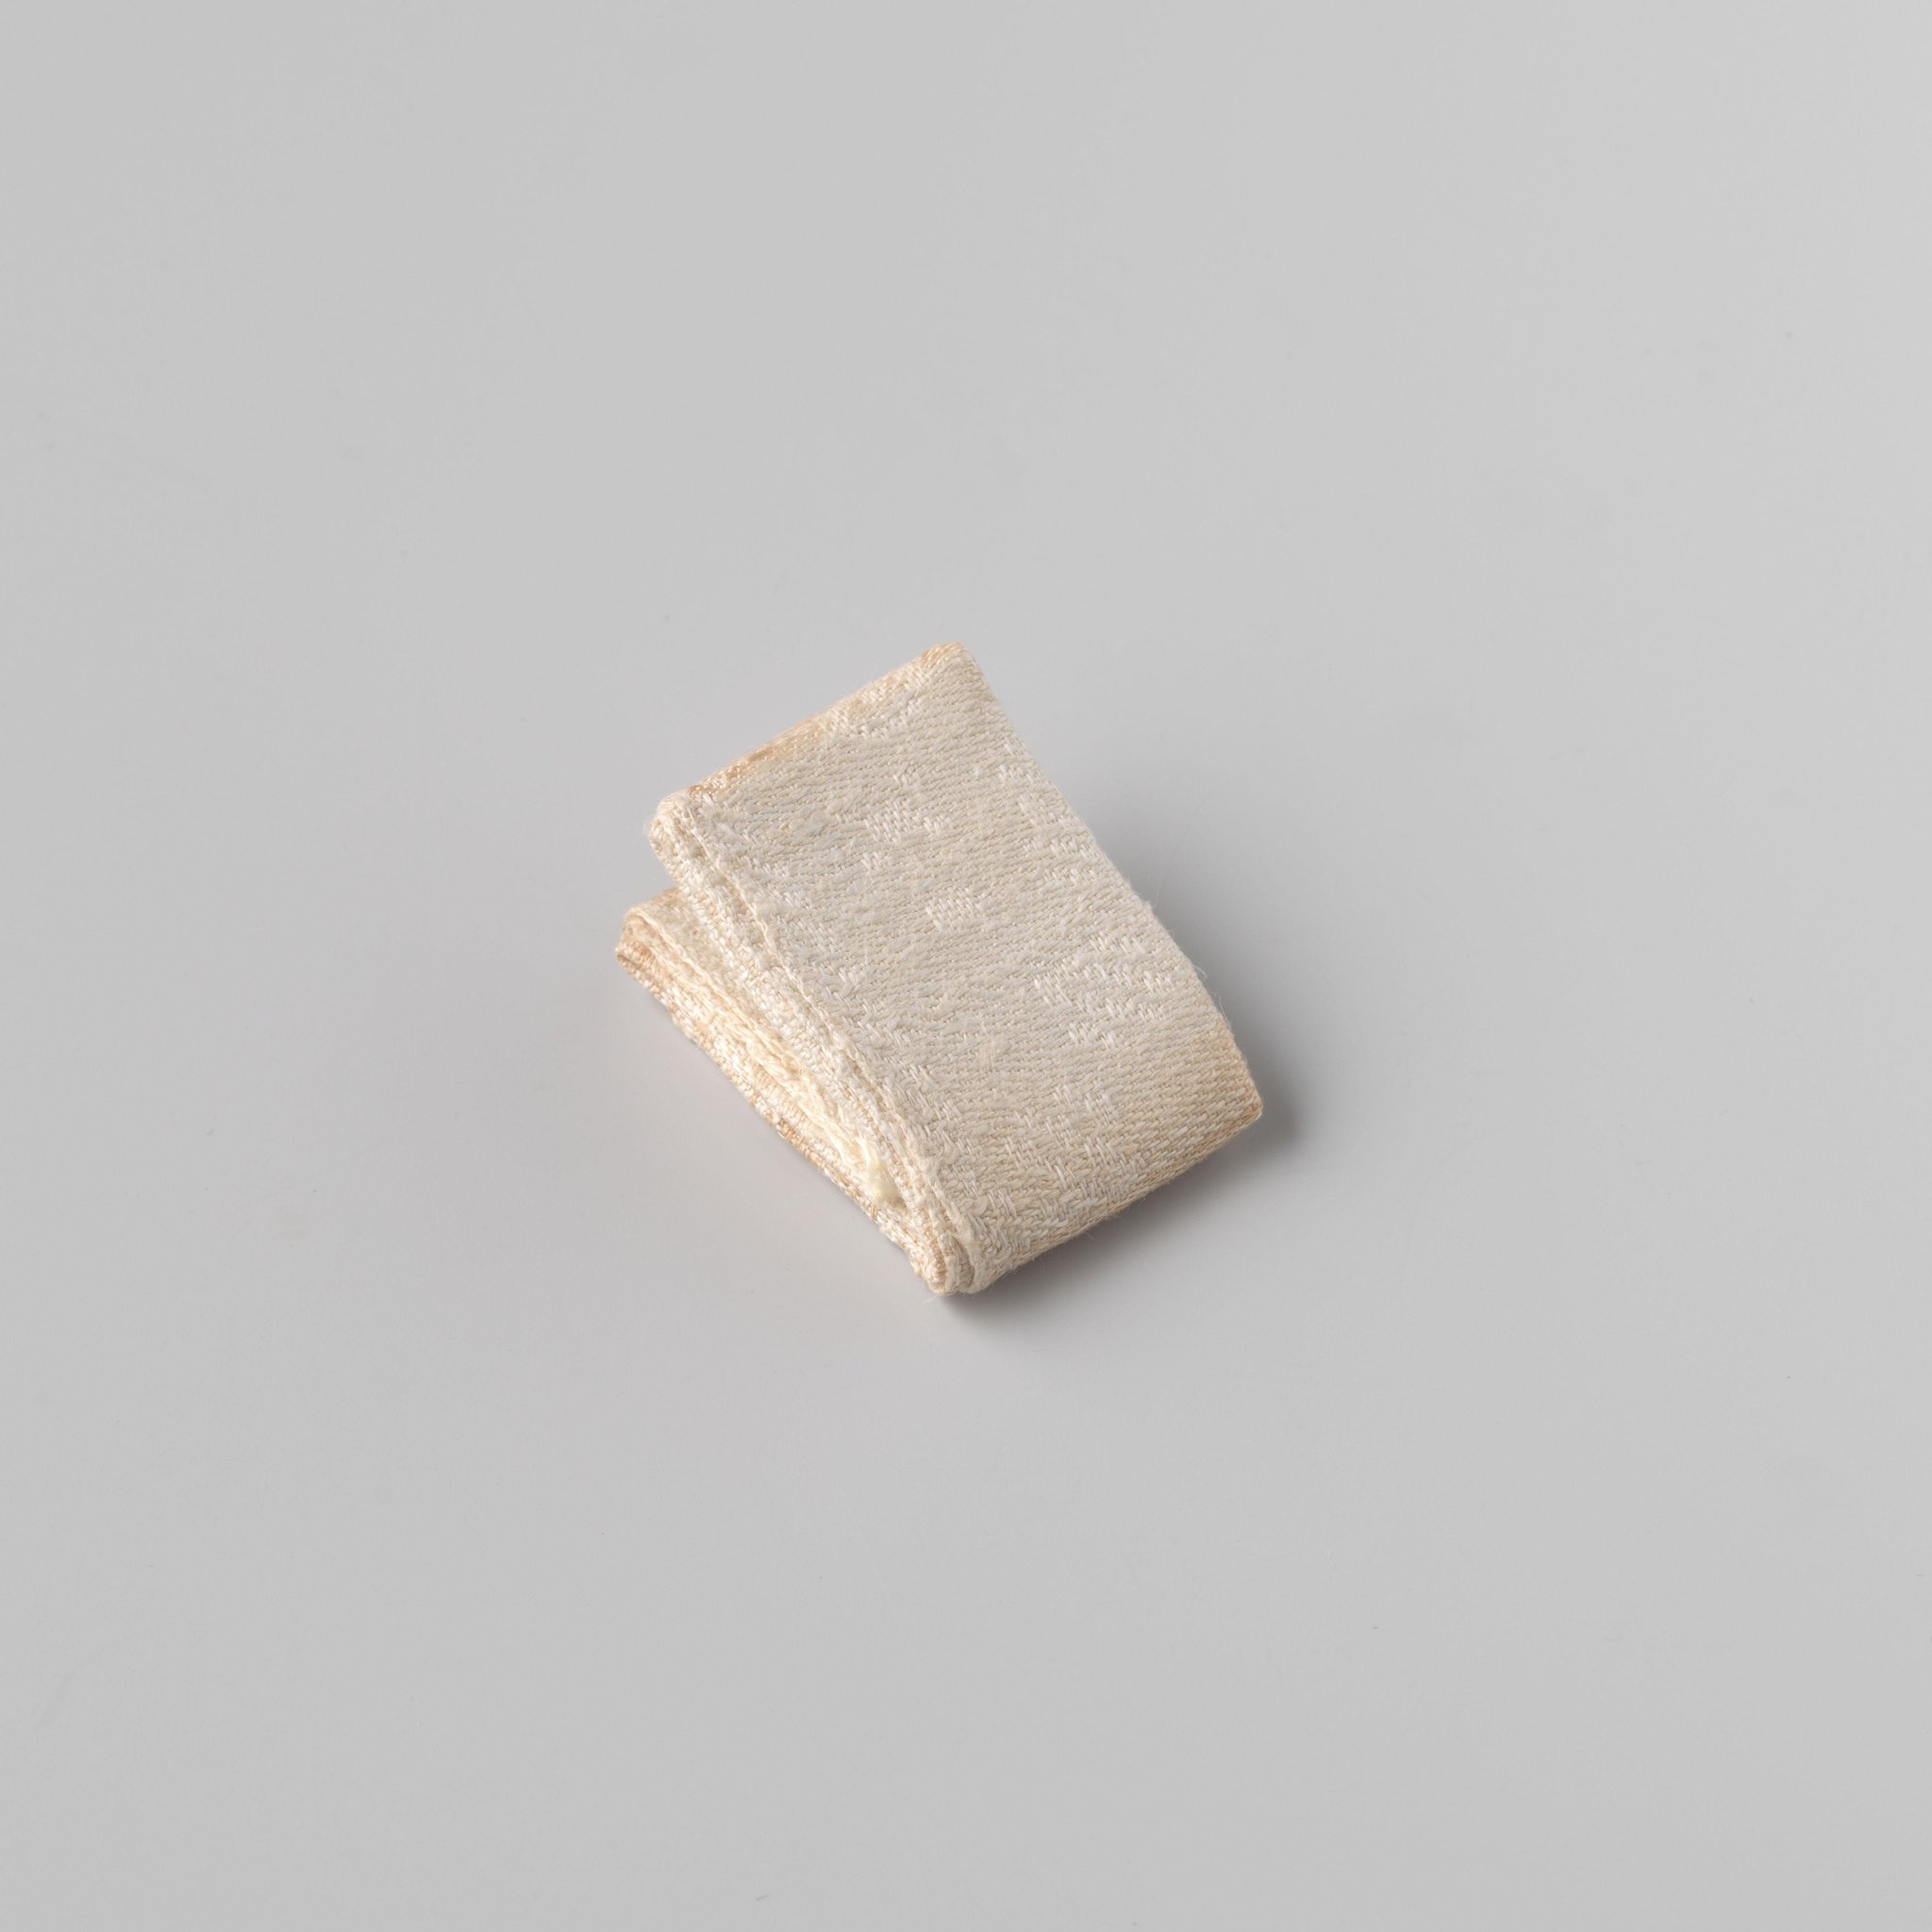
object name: miniature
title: Linnen servet van damastweefsel, met centraal ingeweven monogram BO, waar boven en onder een vogel met opgeheven poot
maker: Anonymous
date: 1690-1710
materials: linen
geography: amsterdam